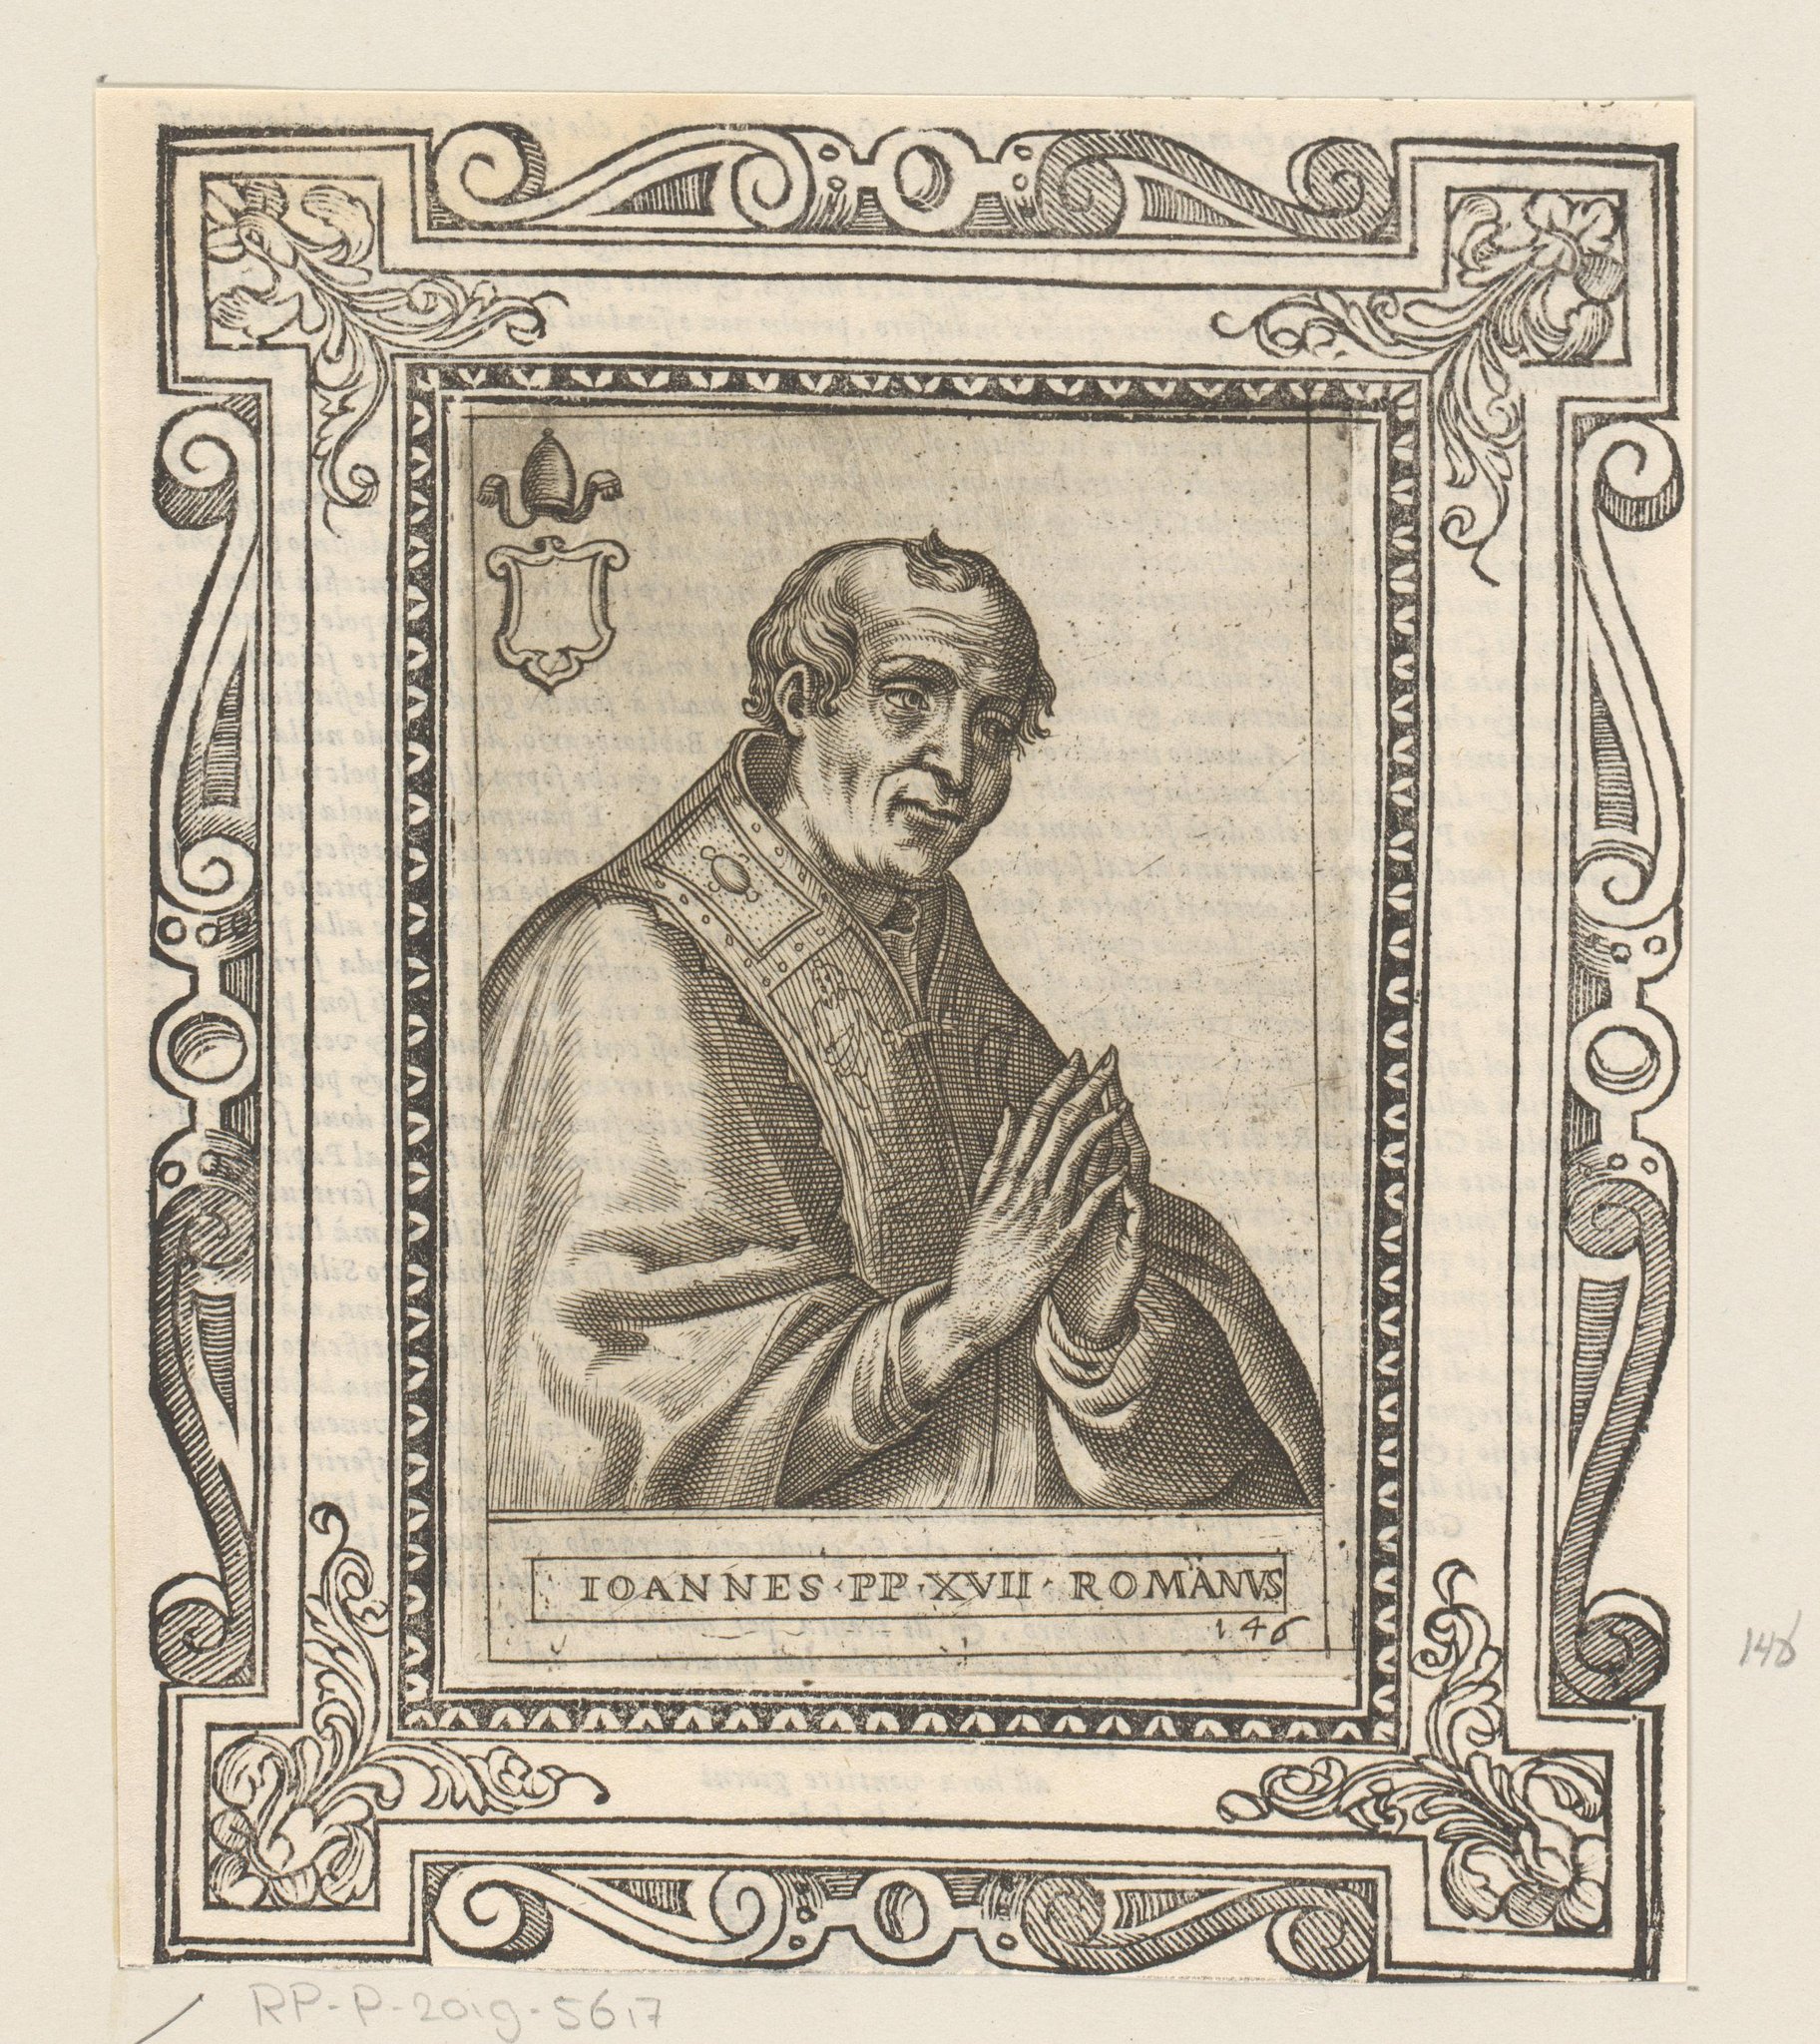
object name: print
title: Joannes PP XVII Romanus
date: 1587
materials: paper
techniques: engraving, letterpress printing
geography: rome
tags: historical persons, pope, armorial bearing, heraldry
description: Prent uit: Ciccarelli, Antonio. Le vite de Pontefici di Antonio Ciccarelli (...). Rome: Domenico Basa, 1587. Prent voor het eerst verschenen in: Cavalieri, Giovanni Battista de'. Pontificum romanorum effigies (...). Rome: Domenico Basa en Francesco Zanetti, 1580. Prent ook gebruikt in latere publicaties.